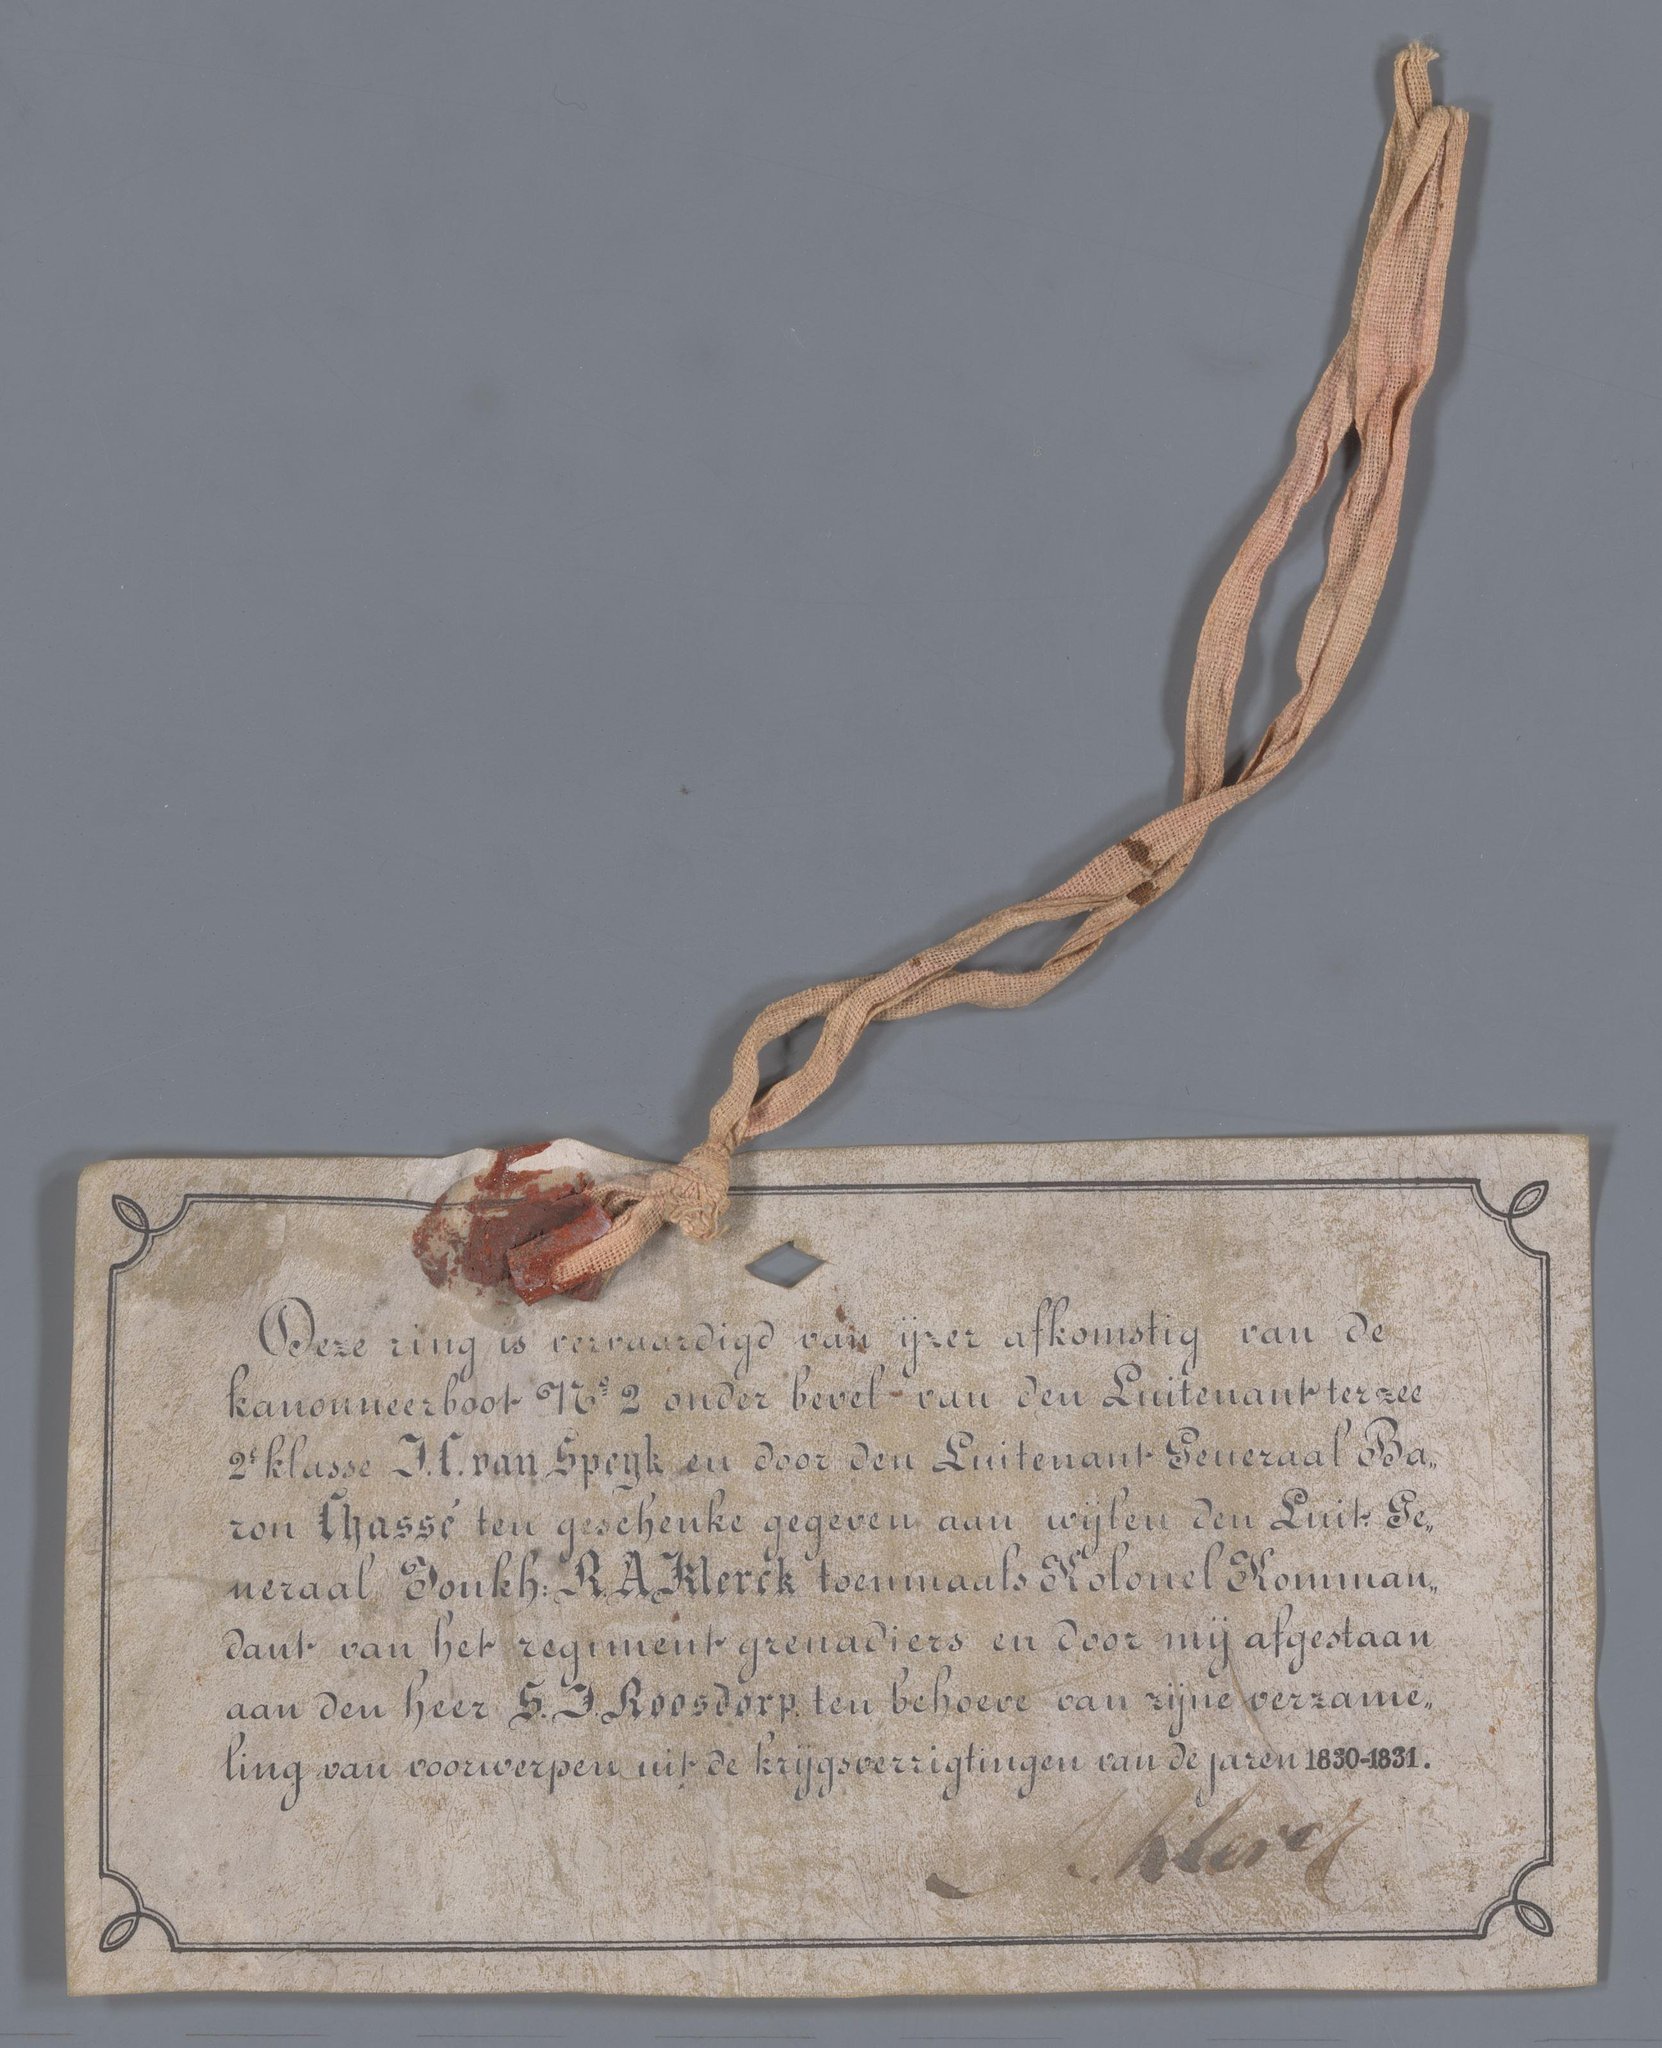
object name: verklaring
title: Verzegelde verklaring van herkomst van de drie ringen van ijzer van de kanonneerboot No.2 van J.C.J. van Speyk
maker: a. klerck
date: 1831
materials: cotton, lacquer, parchment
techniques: printing, knotting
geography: netherlands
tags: amsterdam, antwerp, jan van speyk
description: On 5 October 1833 the amount raised by the lottery was announced. After costs the lottery made ? 6484,98. A total of 5723 tickets had been sold and 911 prizes awarded.